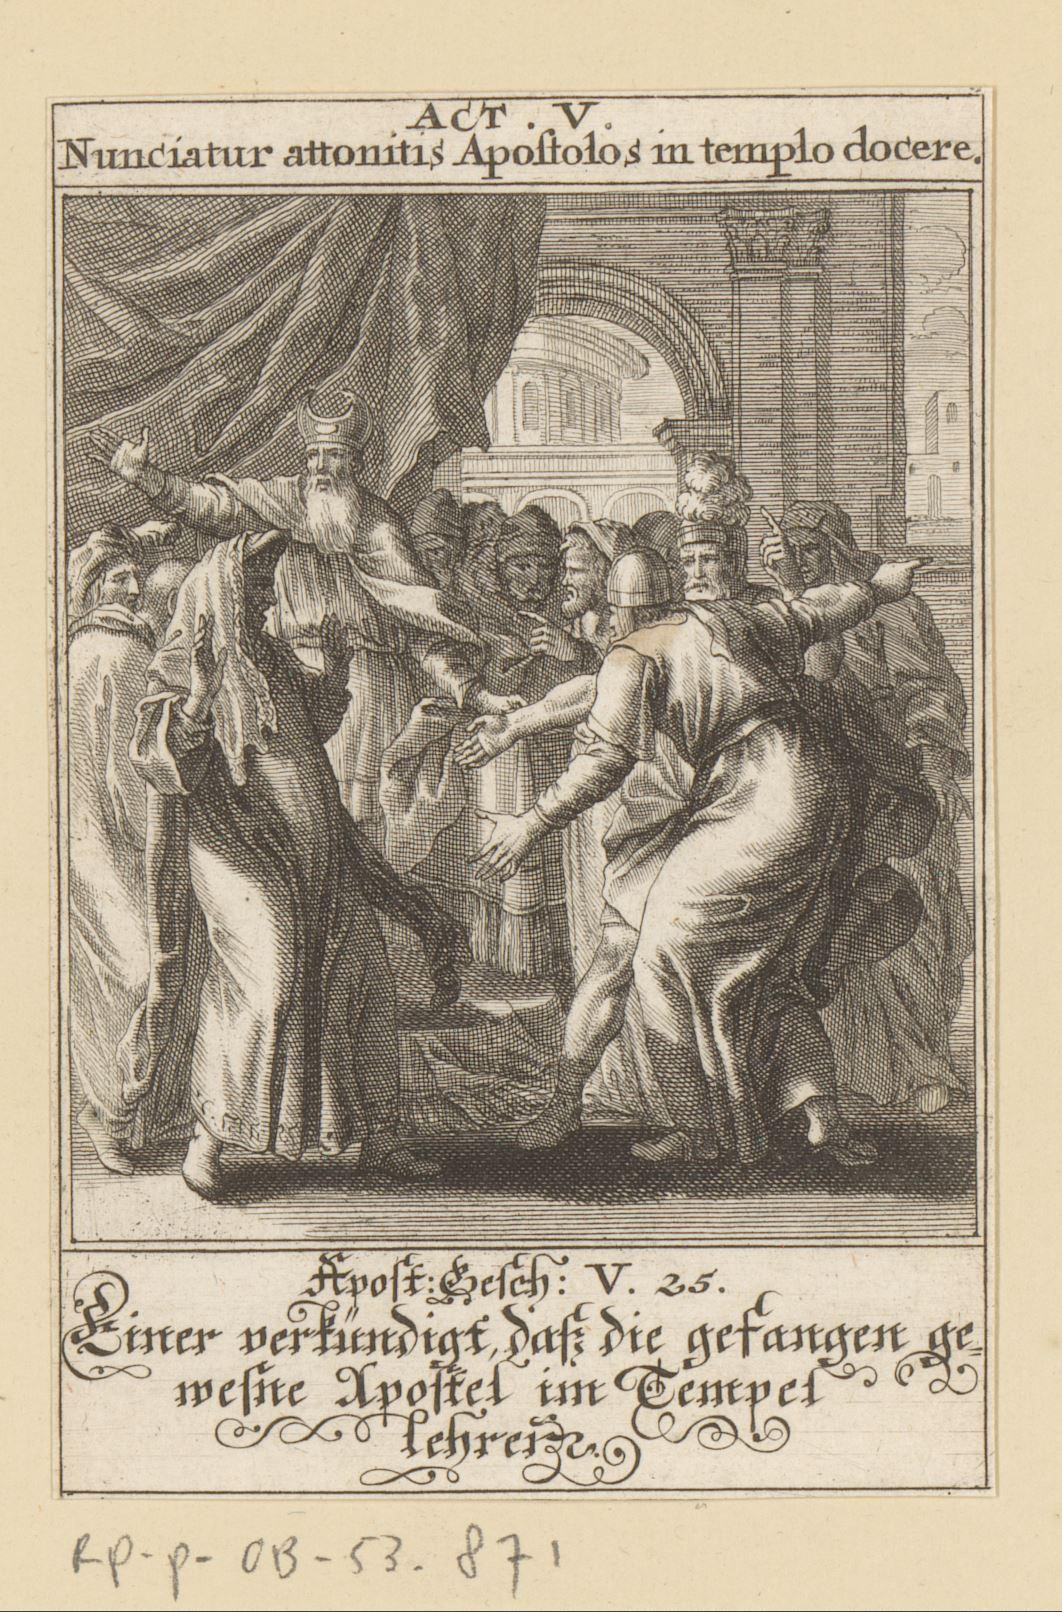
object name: print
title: Ontsnapte apostelen onderrichten weer in de tempel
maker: Anonymous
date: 1697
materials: paper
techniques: etching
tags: in the morning officers find the doors of the prison closed and the apostles gone; they are preaching again in the temple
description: Prent ook gebruikt in: Biblia ectypa : Bildnussen auss Heiliger Schrifft. Regensburg: Chr. Wiegel, 1697.